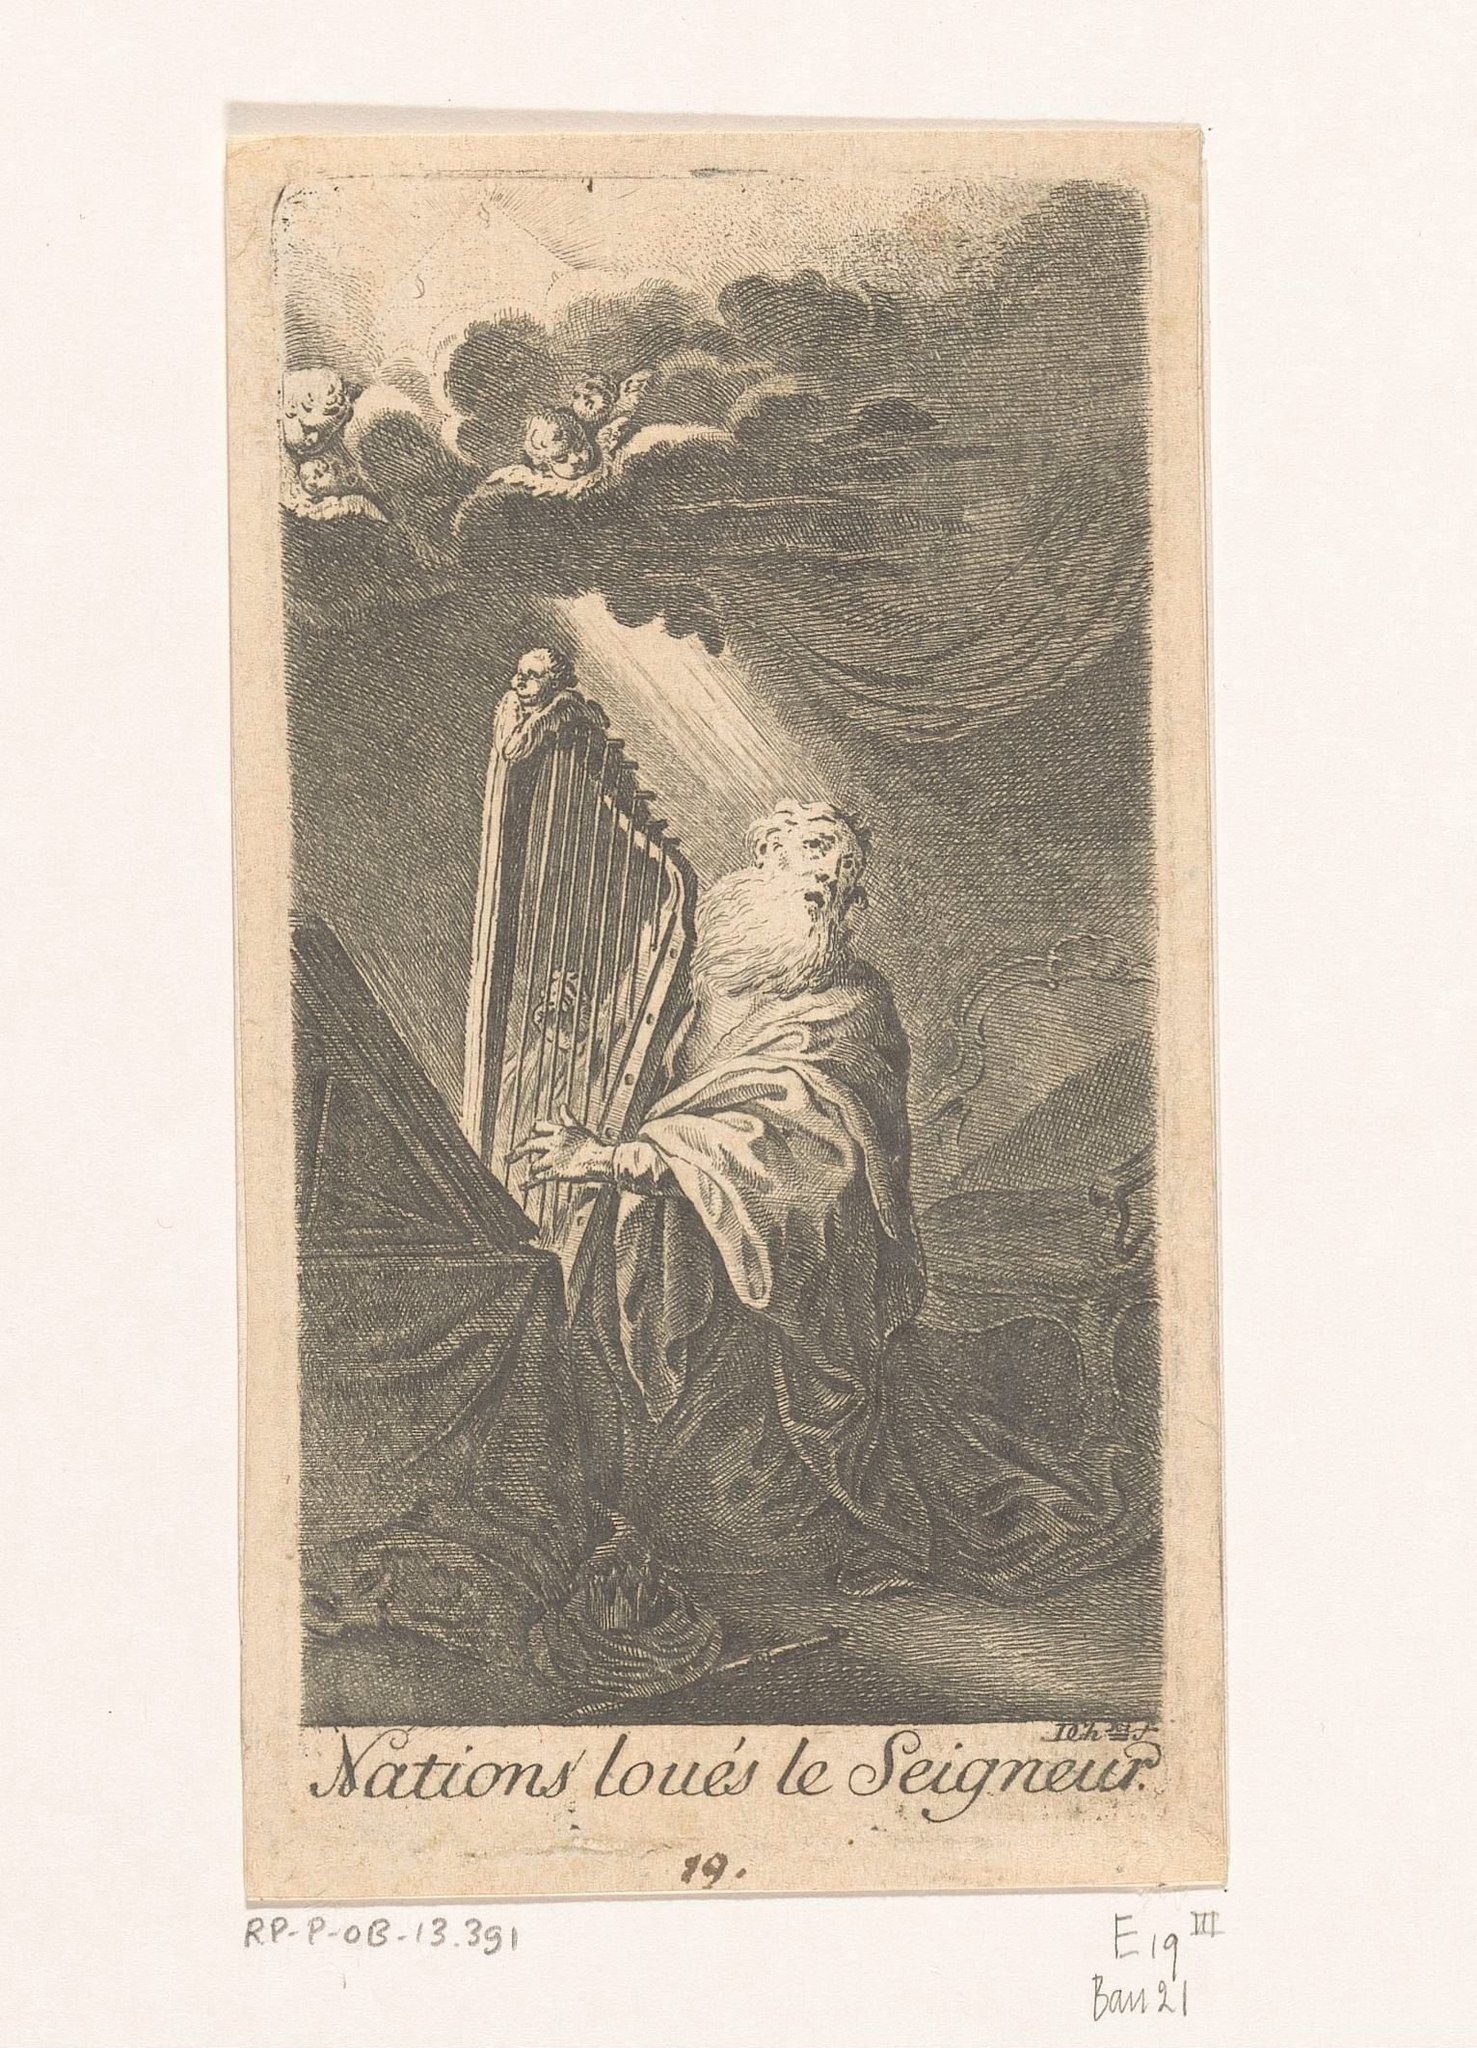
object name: print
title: Nations loués le Seigneur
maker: daniel nikolaus chodowiecki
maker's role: draughtsman, print maker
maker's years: 1726-1801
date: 1759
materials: paper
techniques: etching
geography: berlin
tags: david (not in biblical context); possible attributes: crown, harp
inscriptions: collector's mark: Lugt 2228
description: Prent ook gebruikt in: Les pseaumes des David en vers avec des prières. Berlijn, Aux depens de la Compagnie du Consistroire, 1759.